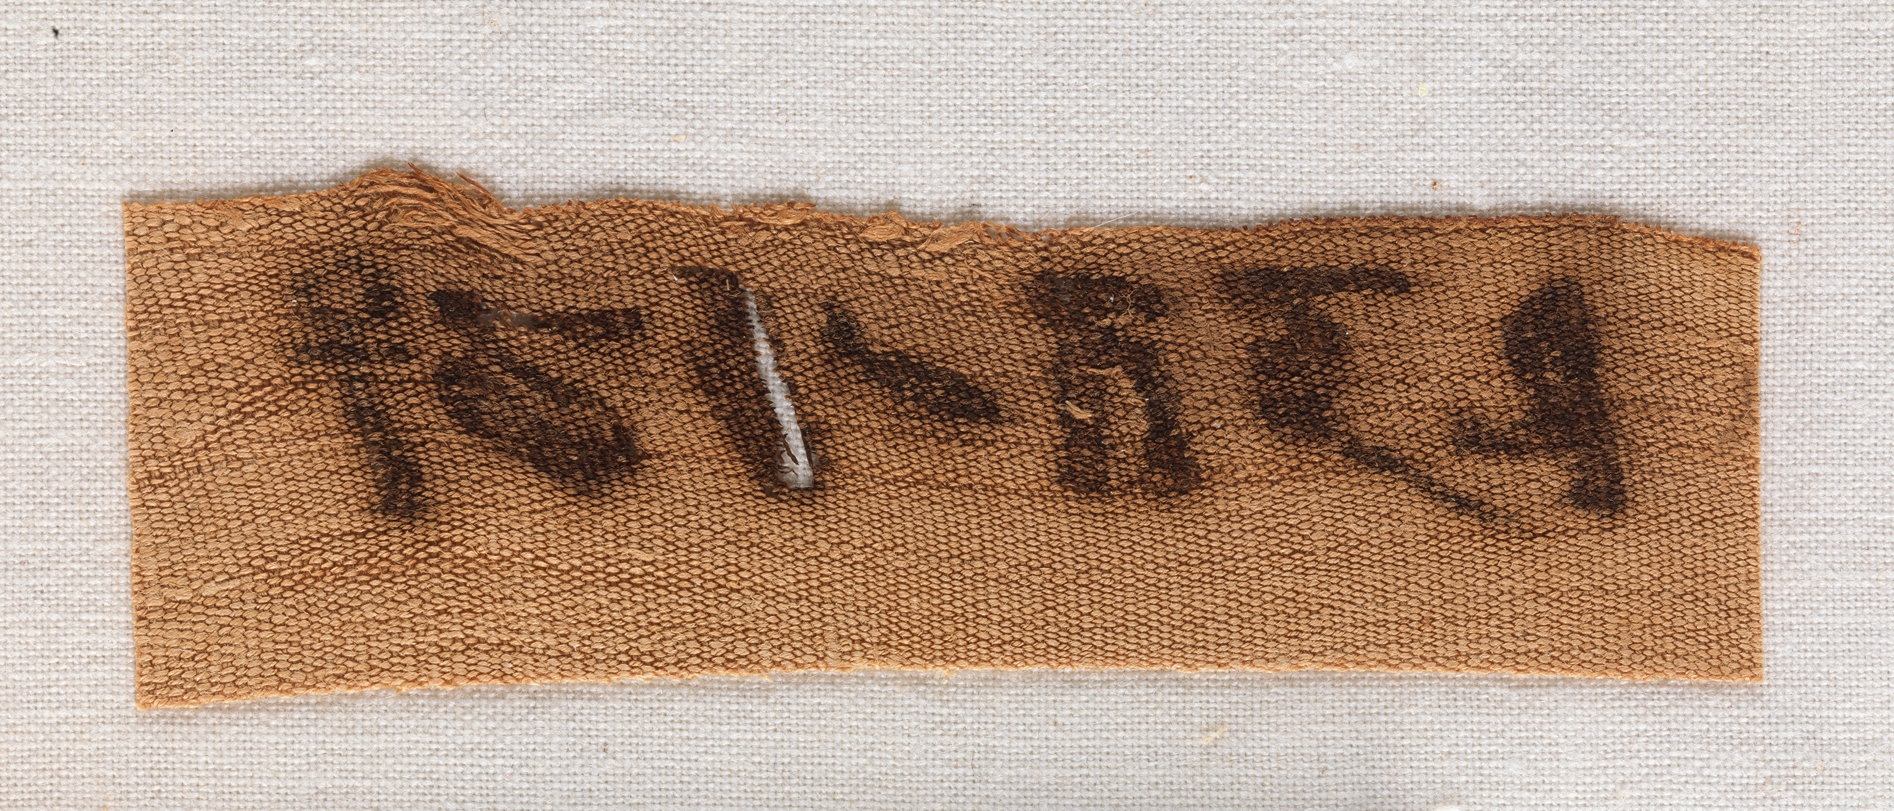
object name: linen mark, myt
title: Linen mark of Myt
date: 2060-2010 BCE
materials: linen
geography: egypt